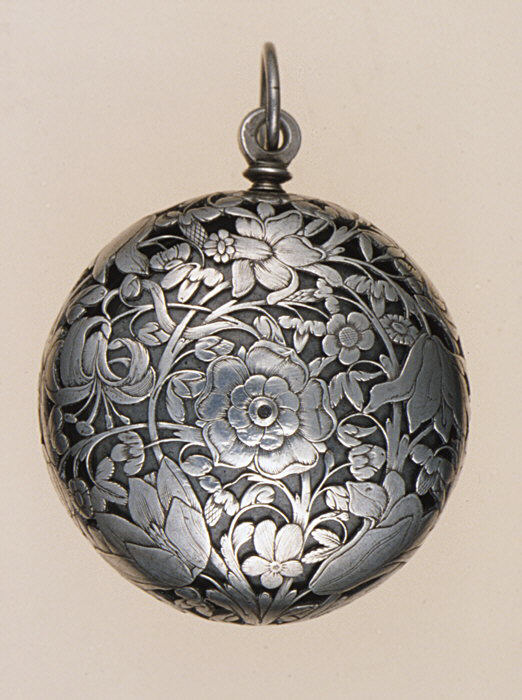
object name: alarm watch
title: Watch with alarm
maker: abraham cusin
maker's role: maker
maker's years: 1651-1682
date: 1660-1670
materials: brass, enamel, gilt, silver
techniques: painting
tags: flowers